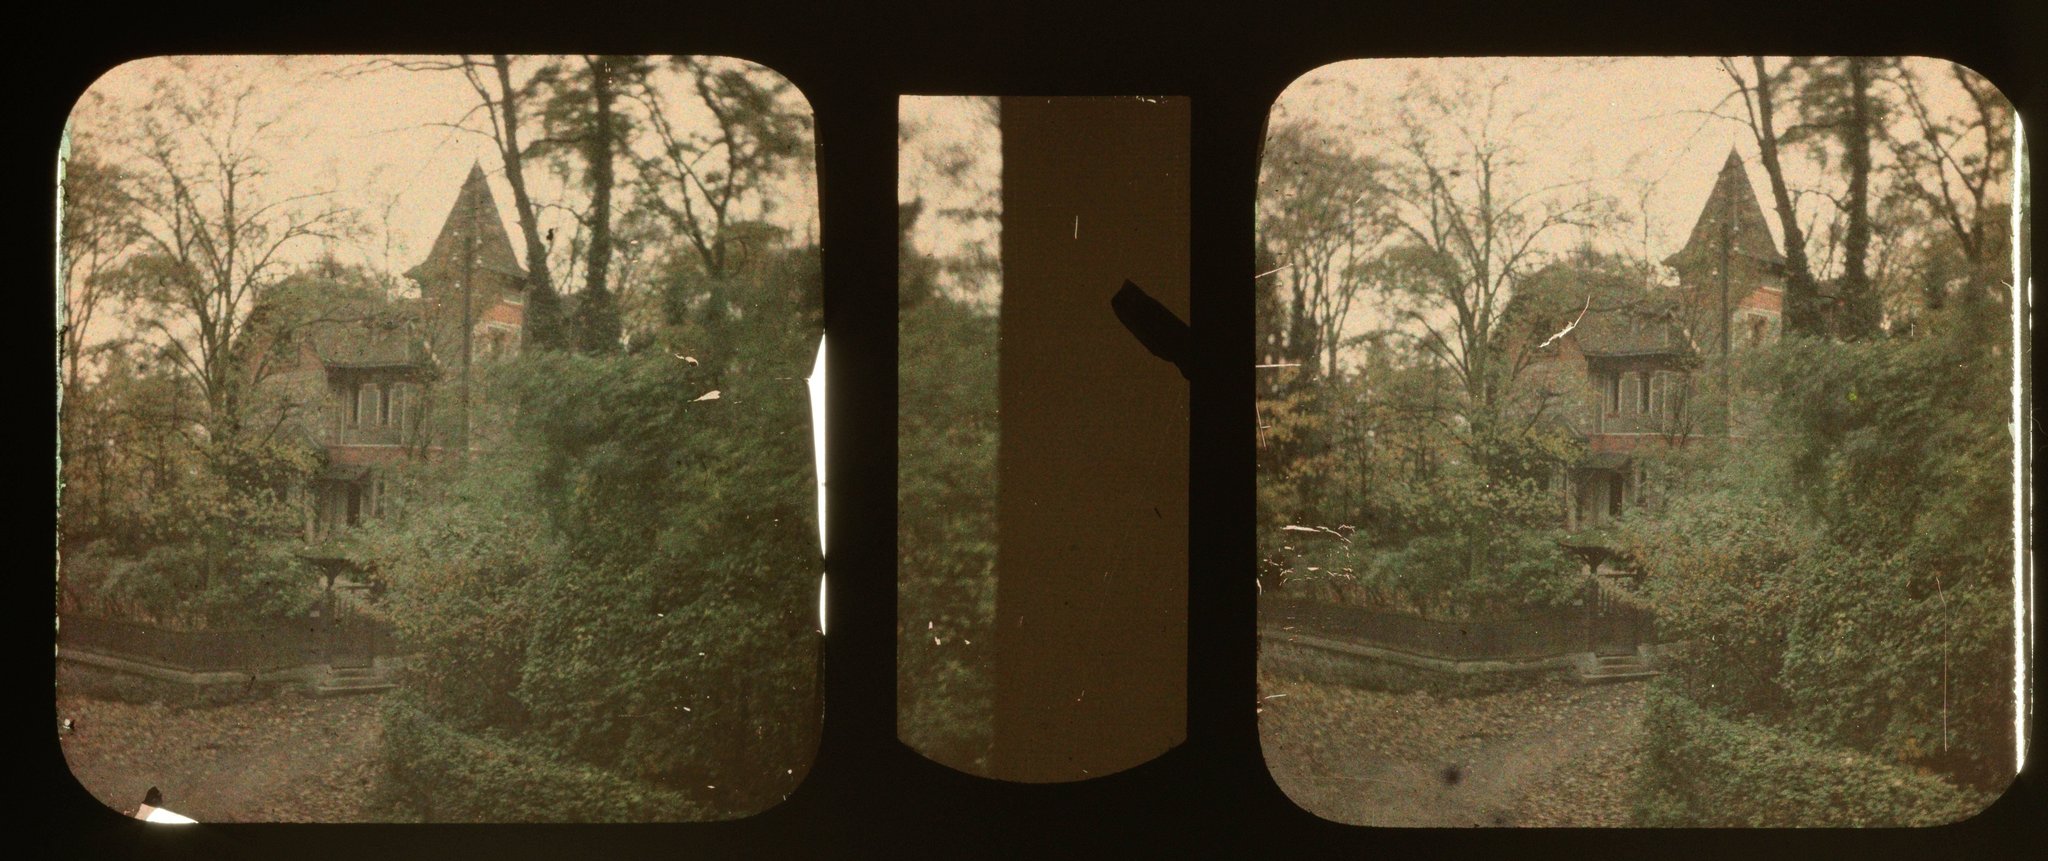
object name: stereoscopic photograph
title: Landhuis tussen bomen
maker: adolphe burdet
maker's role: fotograaf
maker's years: 1860-1940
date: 1907-1935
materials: glass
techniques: autochrome process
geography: netherlands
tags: trees, country-house, netherlands